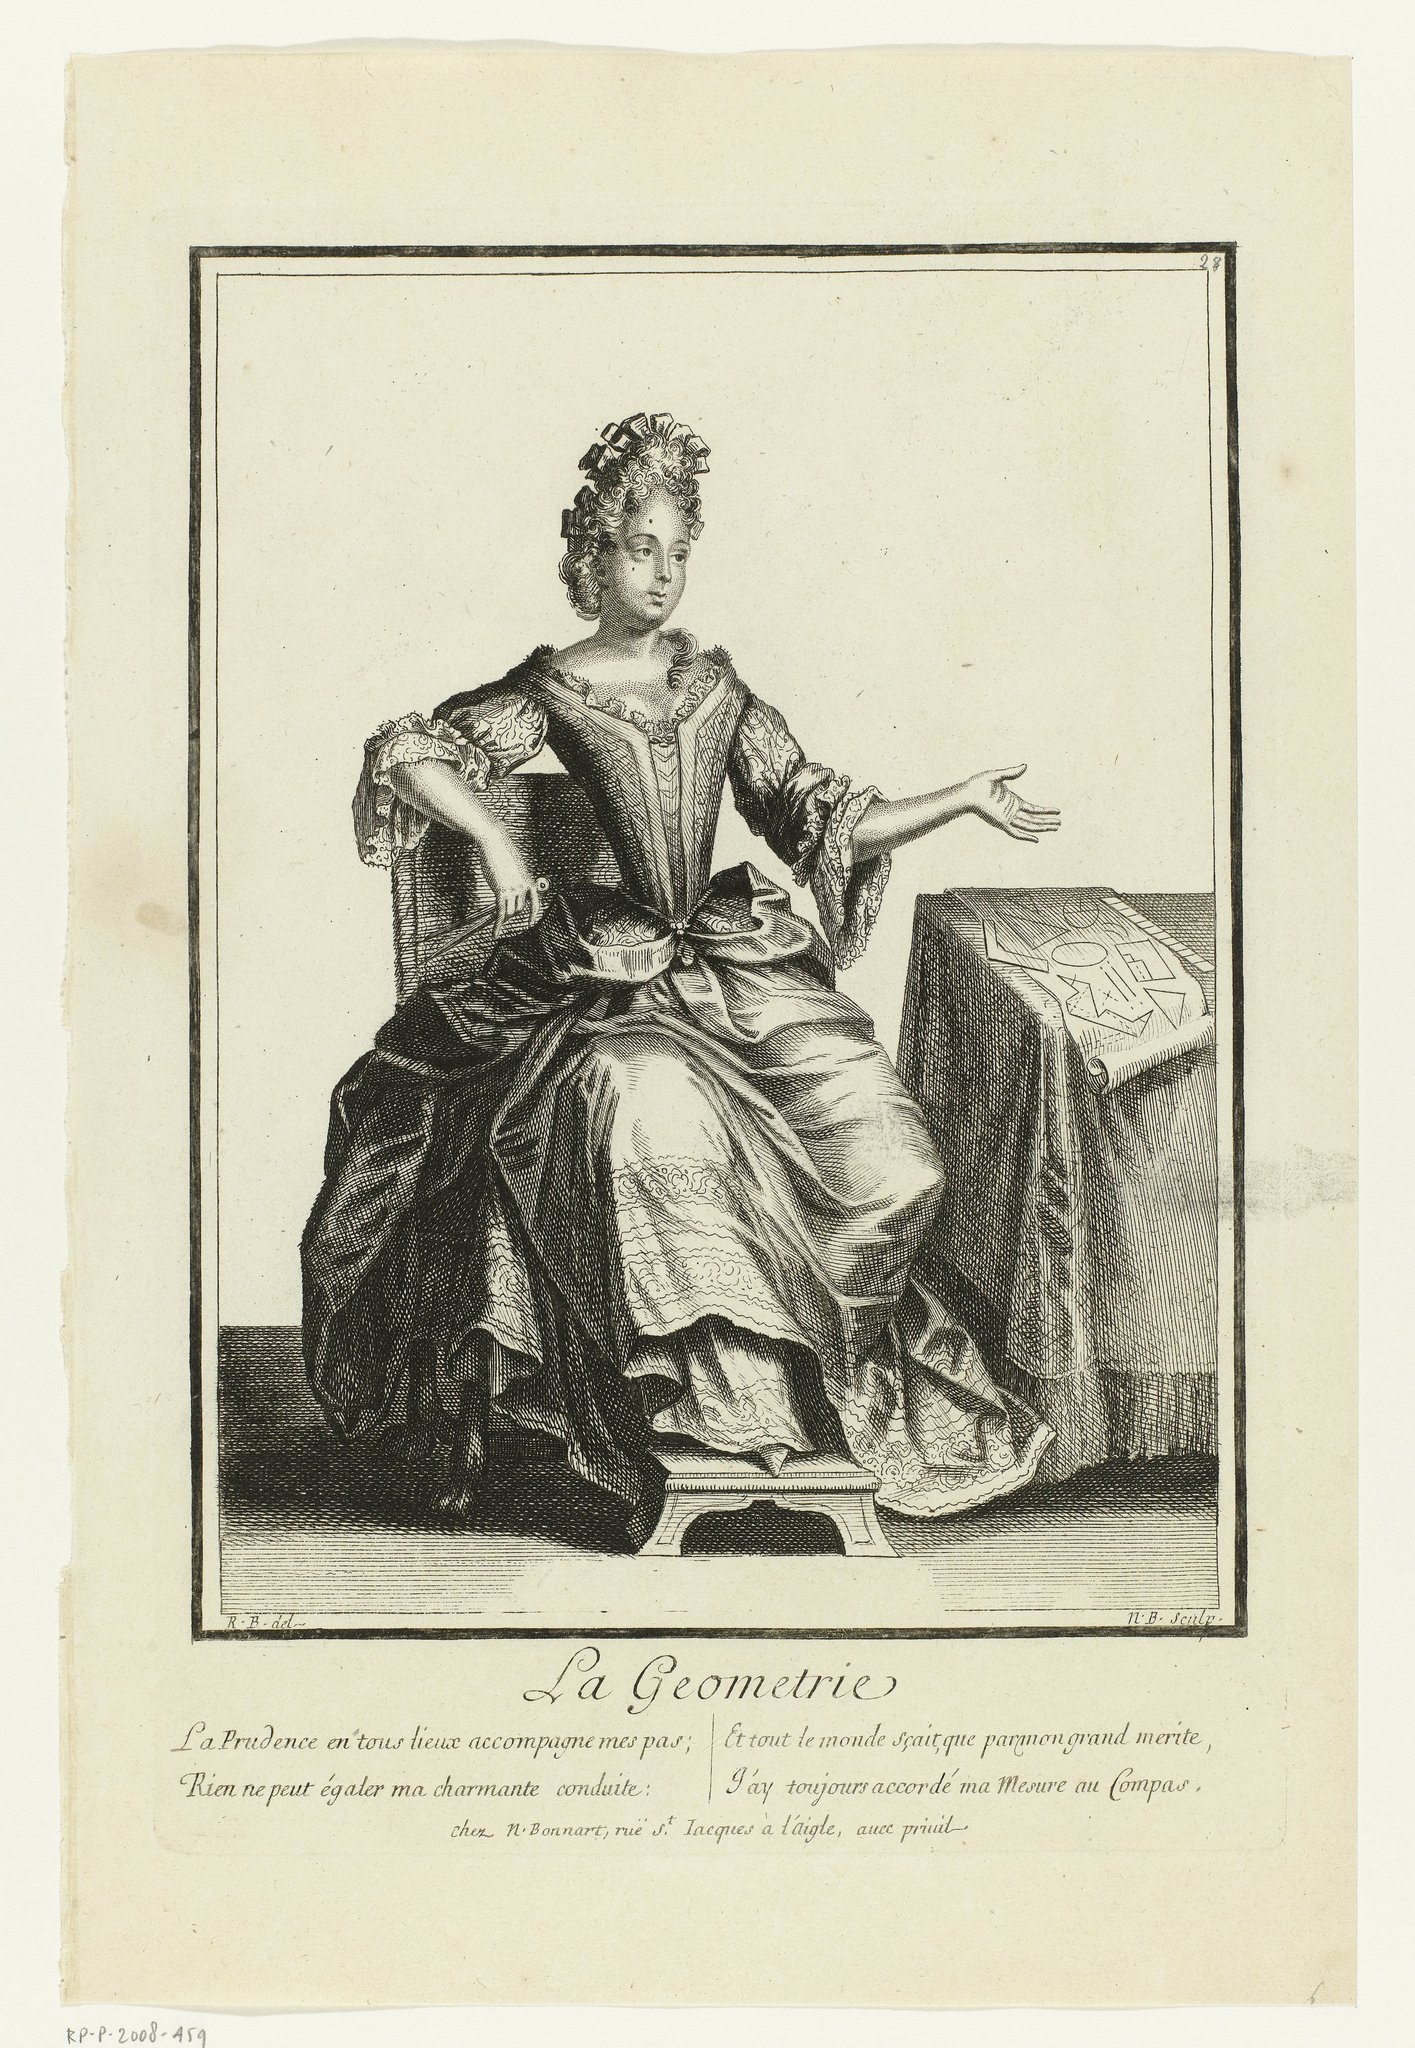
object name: print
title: La Geometrie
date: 1647-1718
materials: paper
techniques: engraving, etching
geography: france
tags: 'geometria' (~ quadrivium); 'geometria' (ripa), styles of hairdress (with name) - aa - ~ women, dress, gown (+ women's clothes)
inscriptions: collector's mark: Lugt 2760, collector's mark: Lugt 2228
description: Vrouw met strikken in haar fontange, zittend aan een tafel waarop een vel papier met geometrische tekeningen. In haar rechterhand houdt zij een passer.